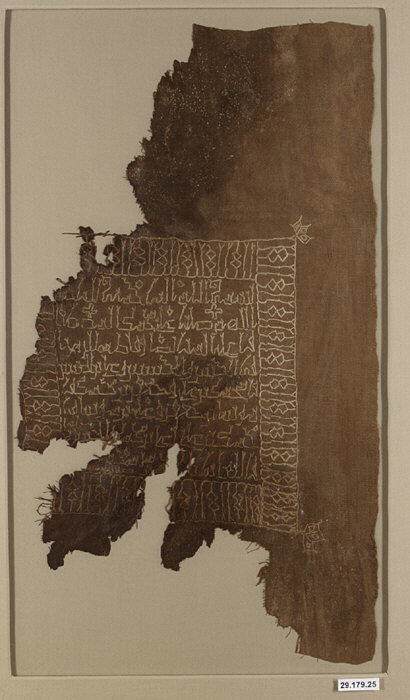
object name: textile fragment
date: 901-1000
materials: cotton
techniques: embroidery, weave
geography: yemen